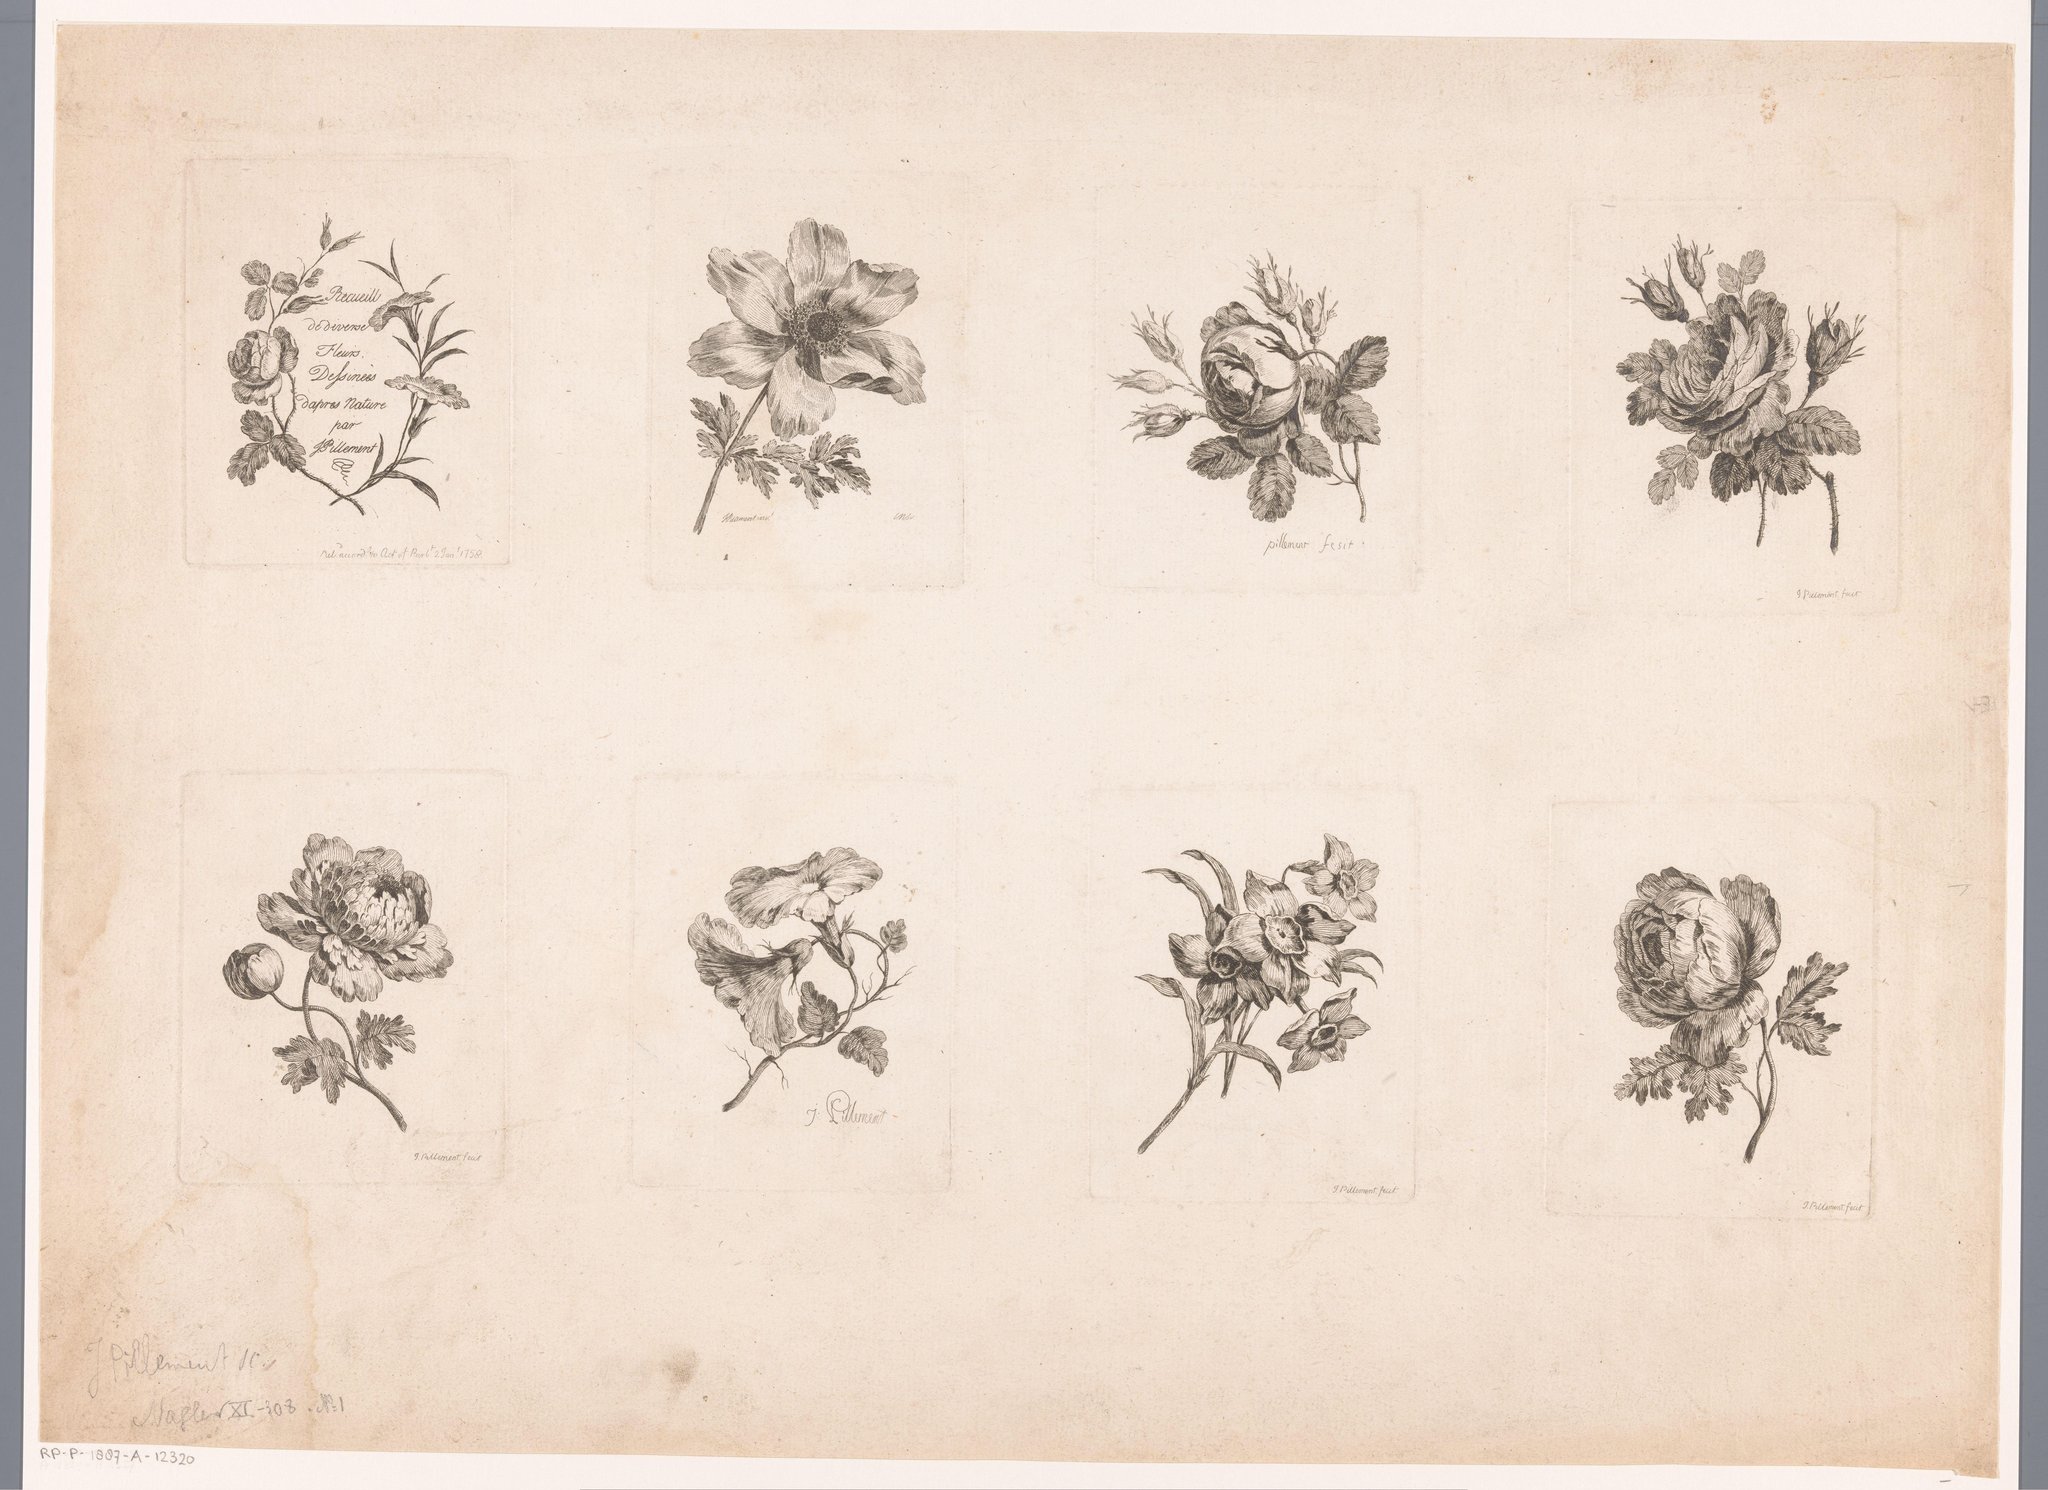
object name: print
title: Recueill de diverse Fleurs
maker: jean baptiste pillement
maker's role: designer, draughtsman, print maker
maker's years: 1728-1808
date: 1758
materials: paper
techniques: etching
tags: flowers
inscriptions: collector's mark: Lugt 2228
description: Acht prenten op een blad. Links boven de serietitel met een rozentak en een tak met trompetbloemen. Daarnaast en daaronder drie en vier verschillende bloemen waaronder diverse rozen.